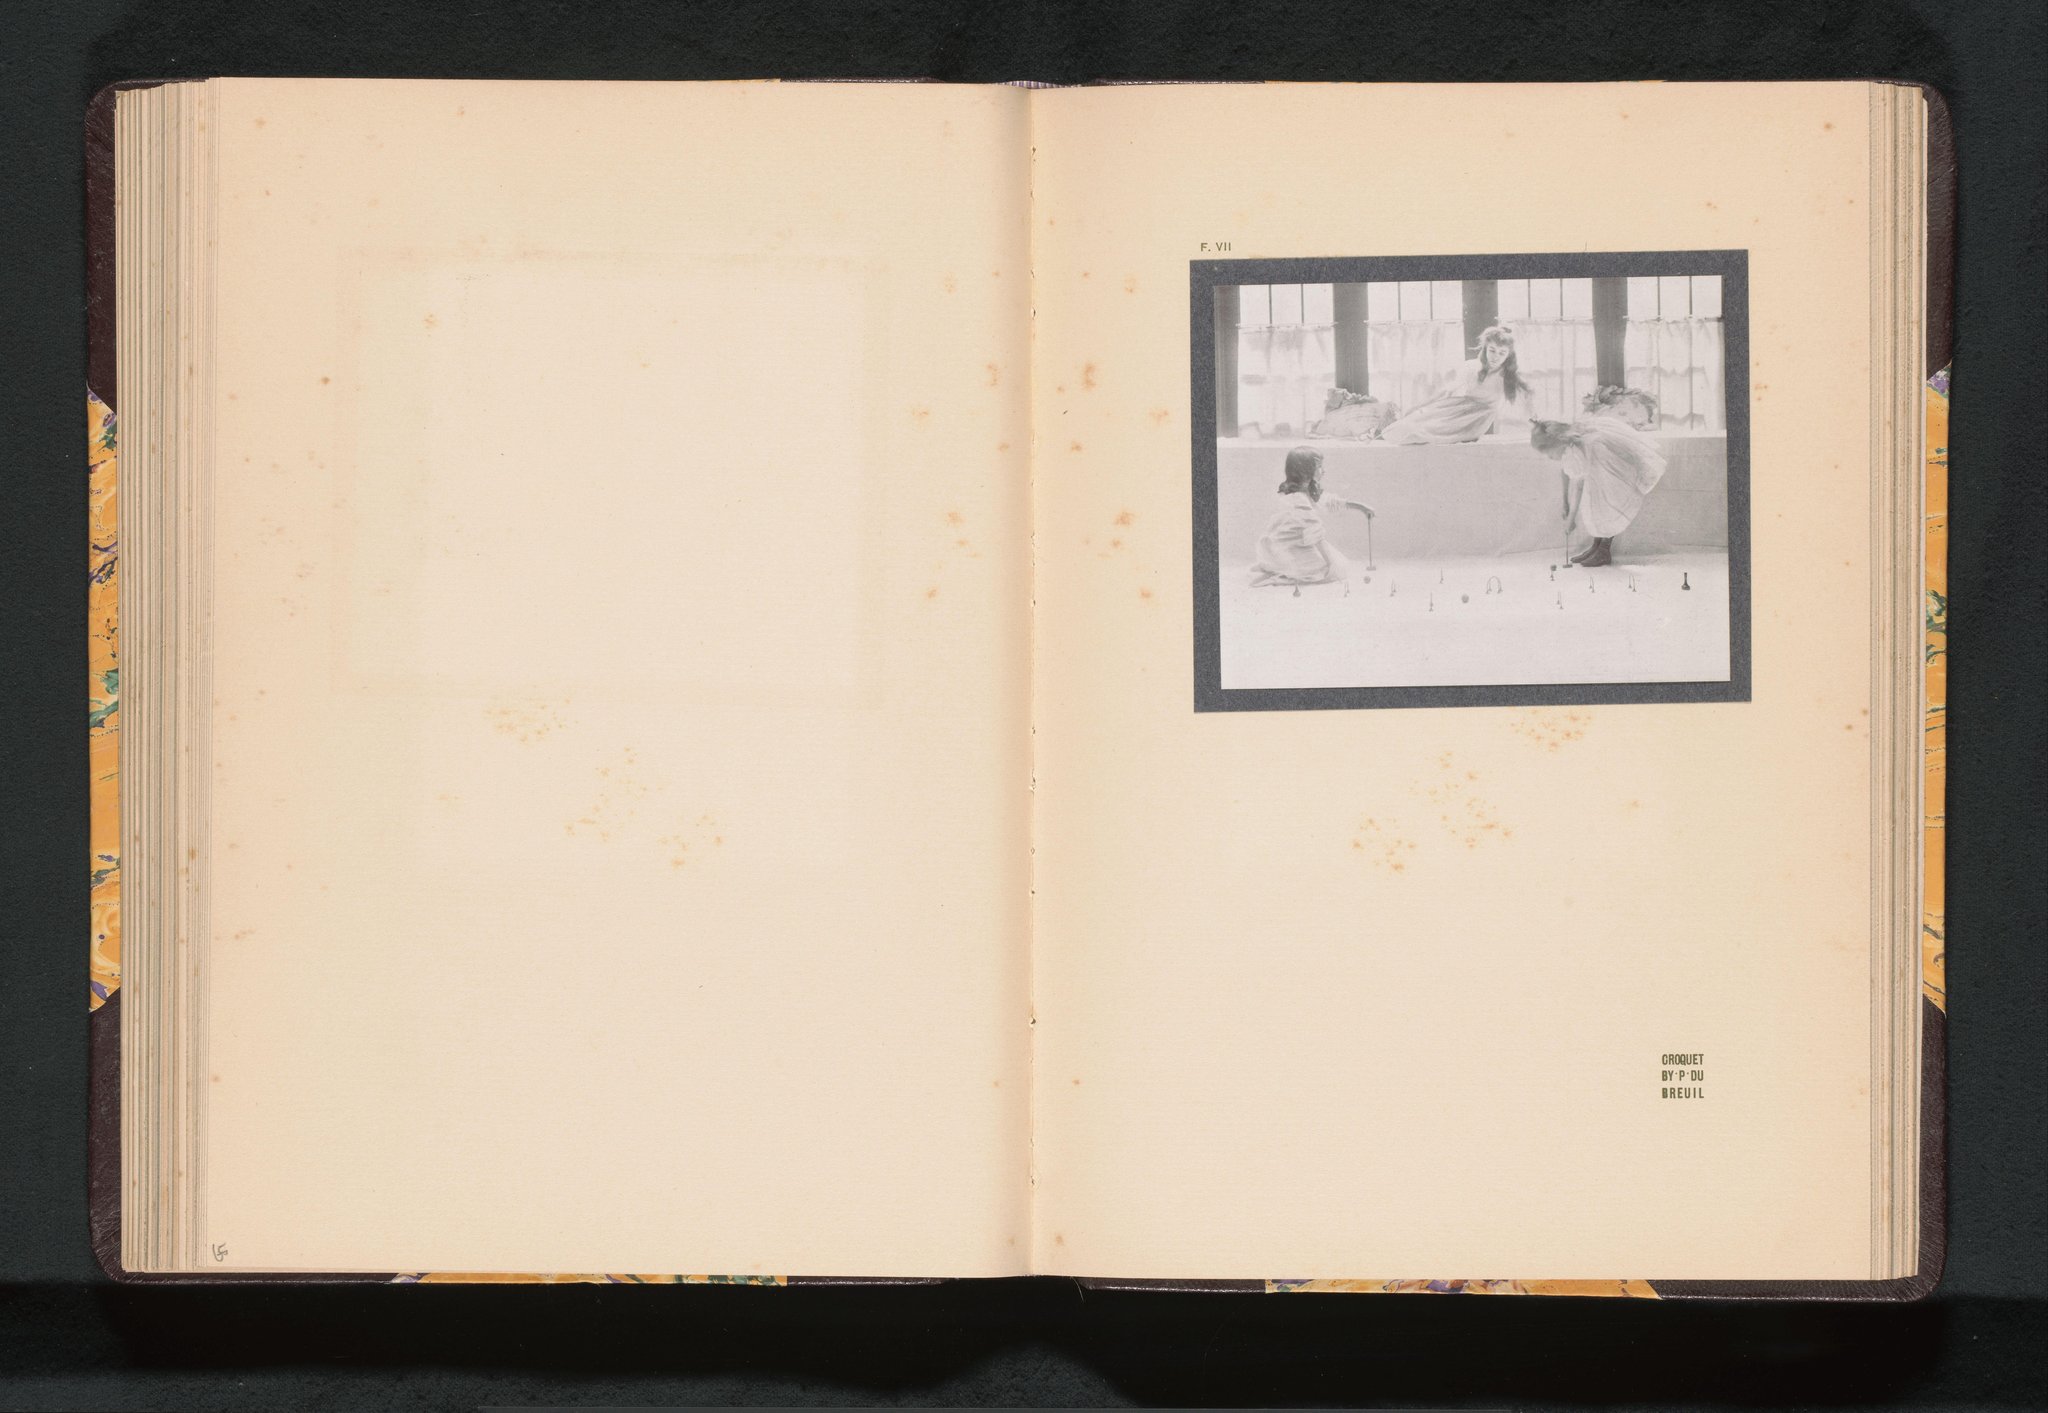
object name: page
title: Drie meisjes spelen croquet binnenshuis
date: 1900-1905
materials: paper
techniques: autotype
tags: adolescent, young woman, maiden, croquet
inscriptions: inscription: ‘F. VII.’, inscription: ‘Croquet by P. Dubreuil’